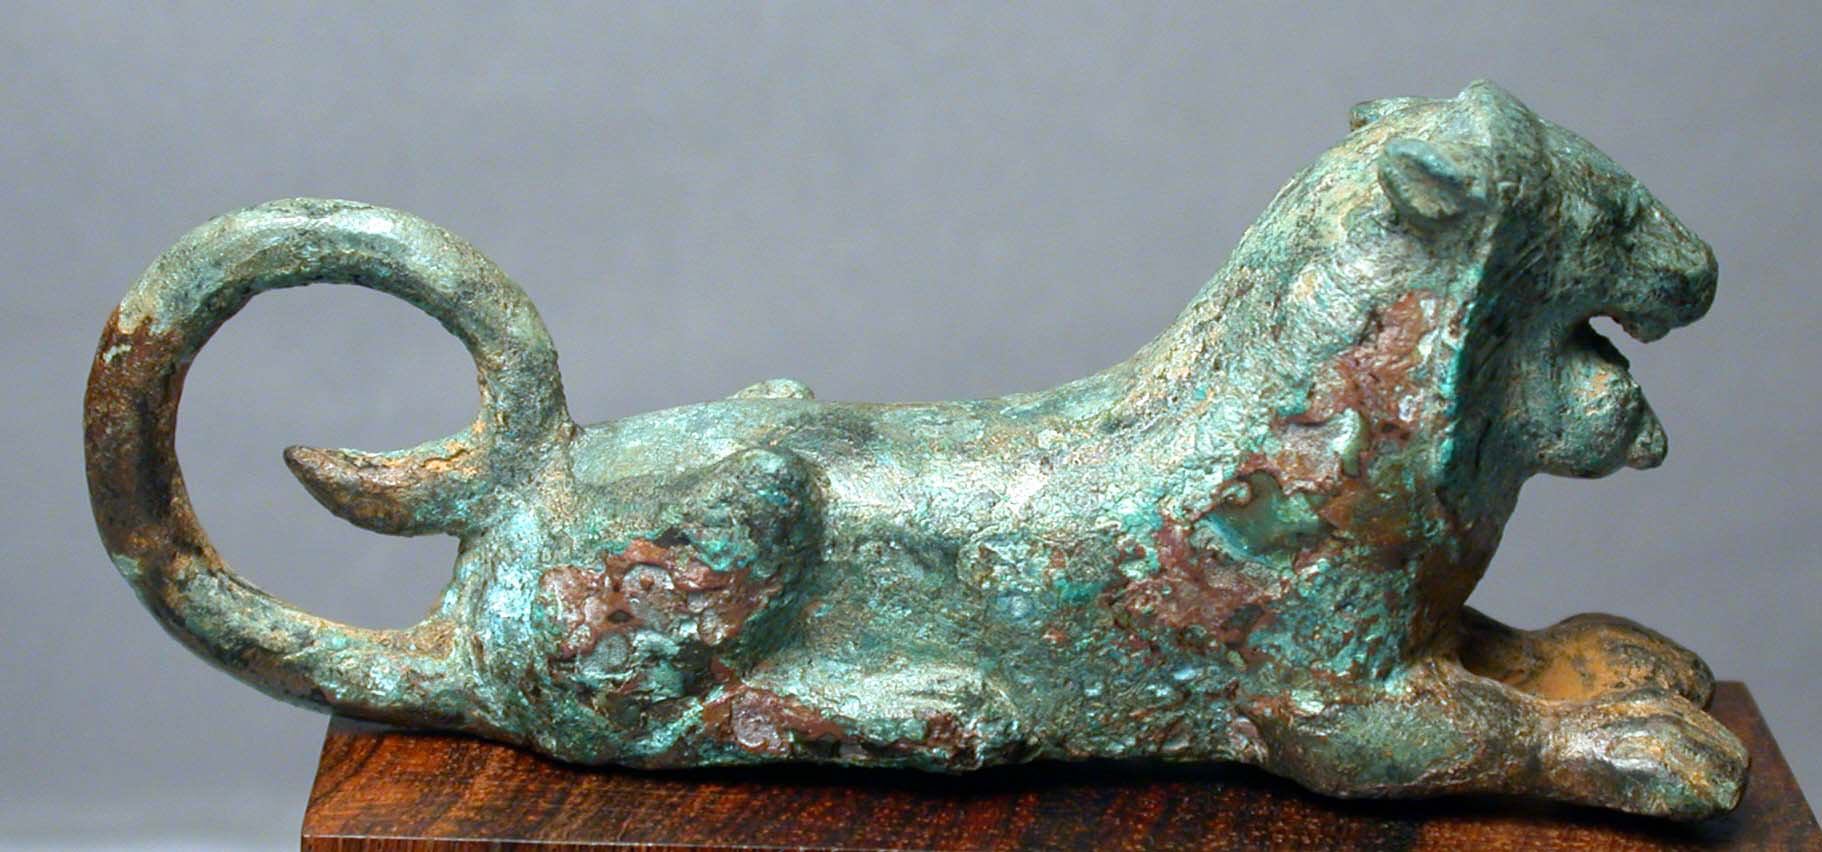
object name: figure of a recumbent lion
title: Bronze figure of a recumbent lion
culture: italic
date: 550-500 BCE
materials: bronze